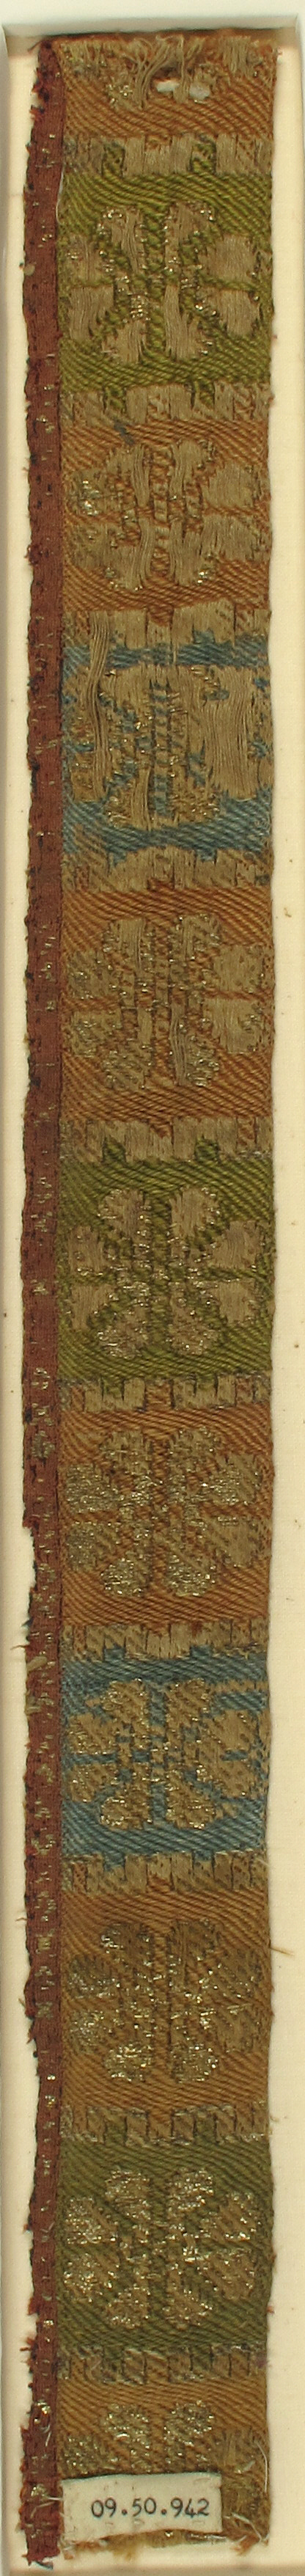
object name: textile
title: Brocade Textile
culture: german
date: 1401-1500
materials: linen, metal thread, silk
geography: germany